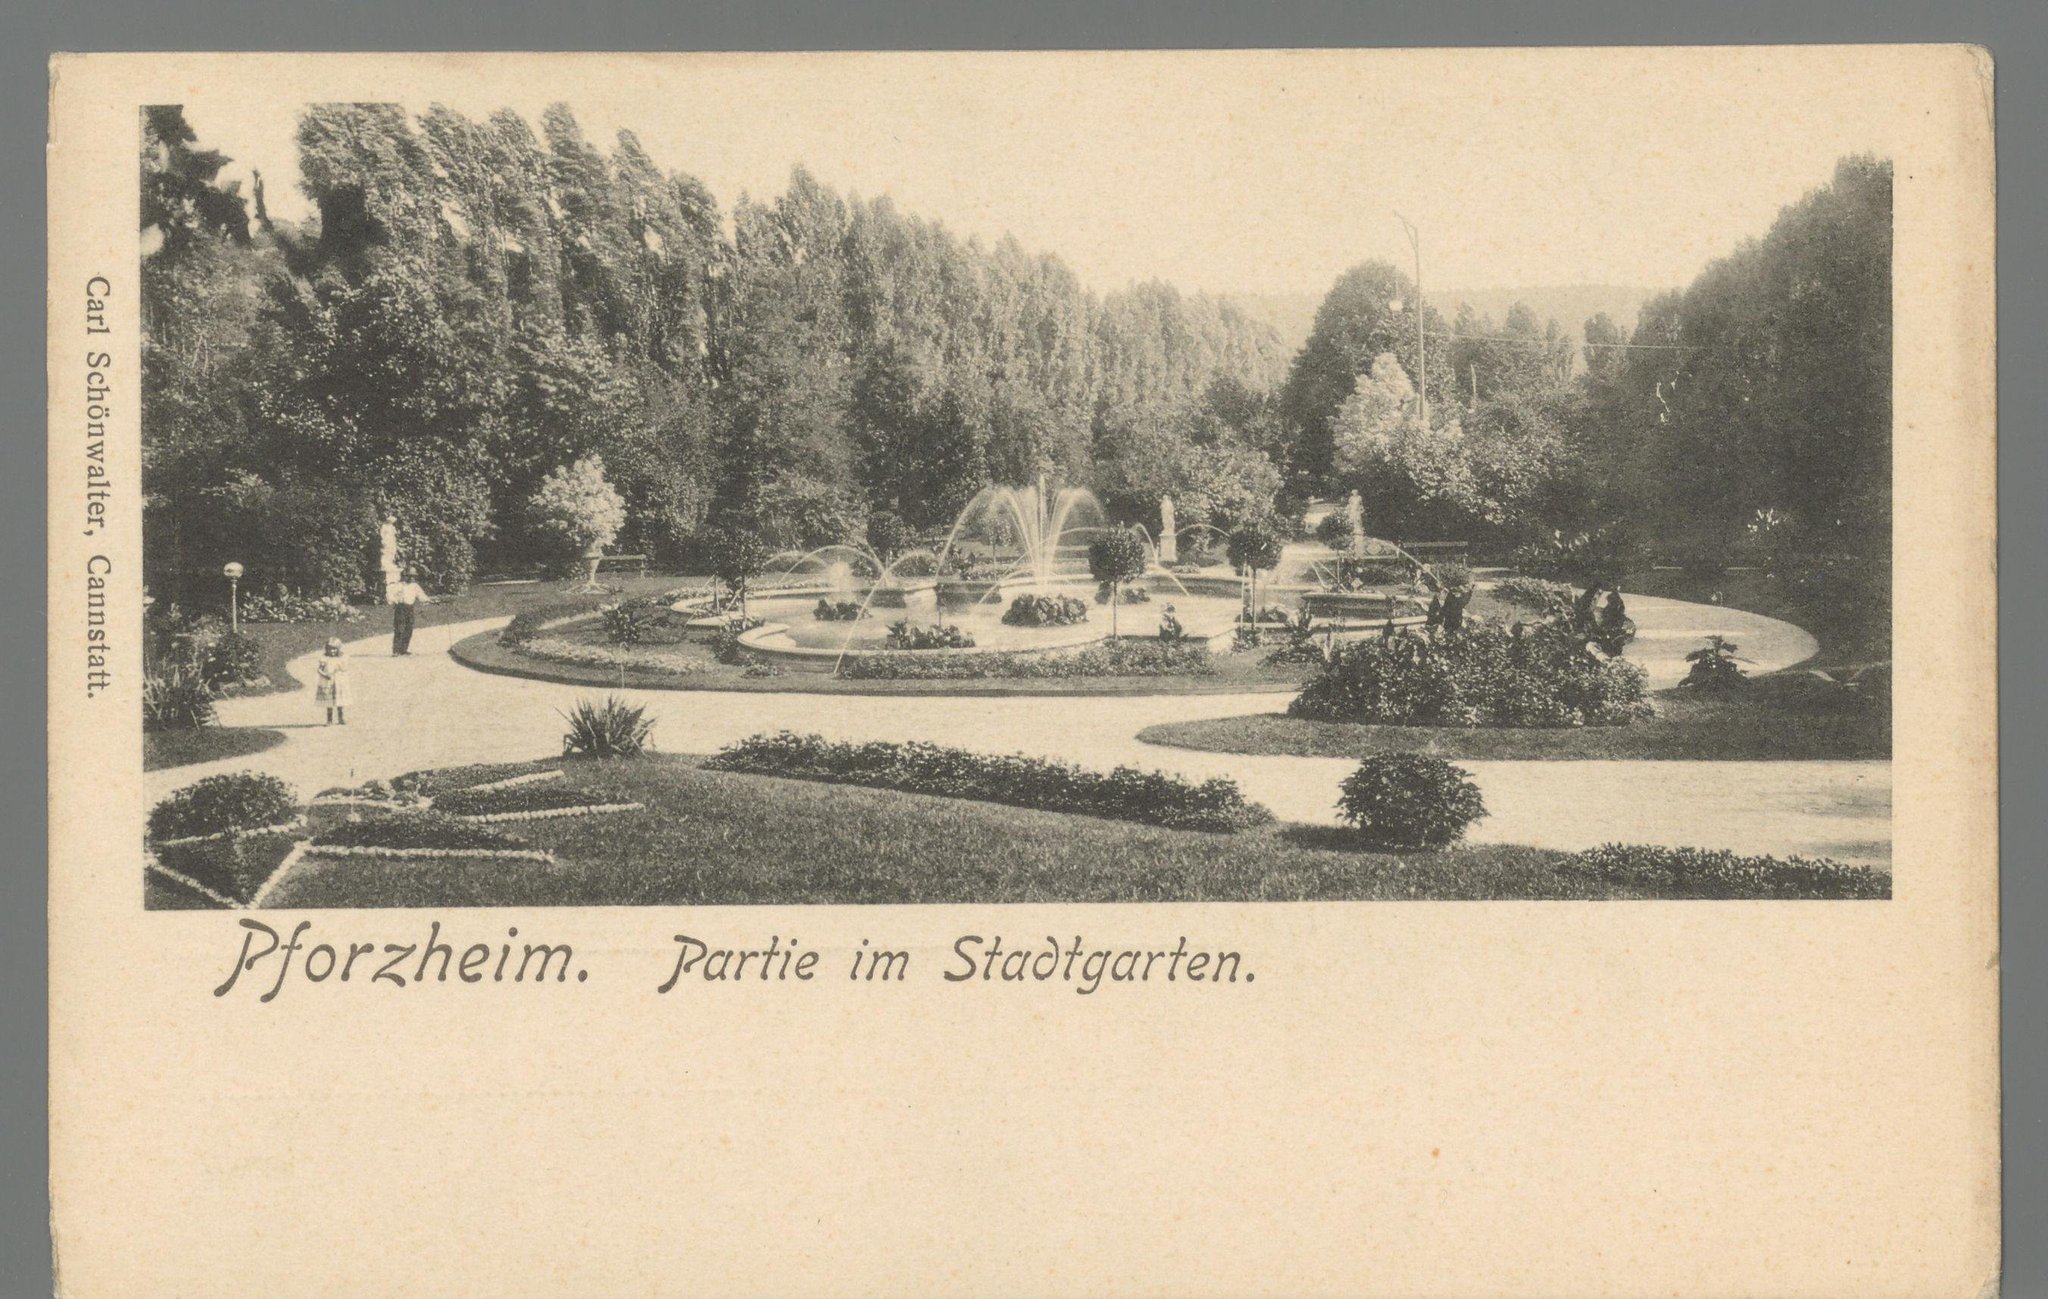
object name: photomechanical print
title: Pforzheim Partie im Stadtgarten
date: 1885-1905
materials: cardboard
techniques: photograph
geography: cannstatt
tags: garden, garden fountain